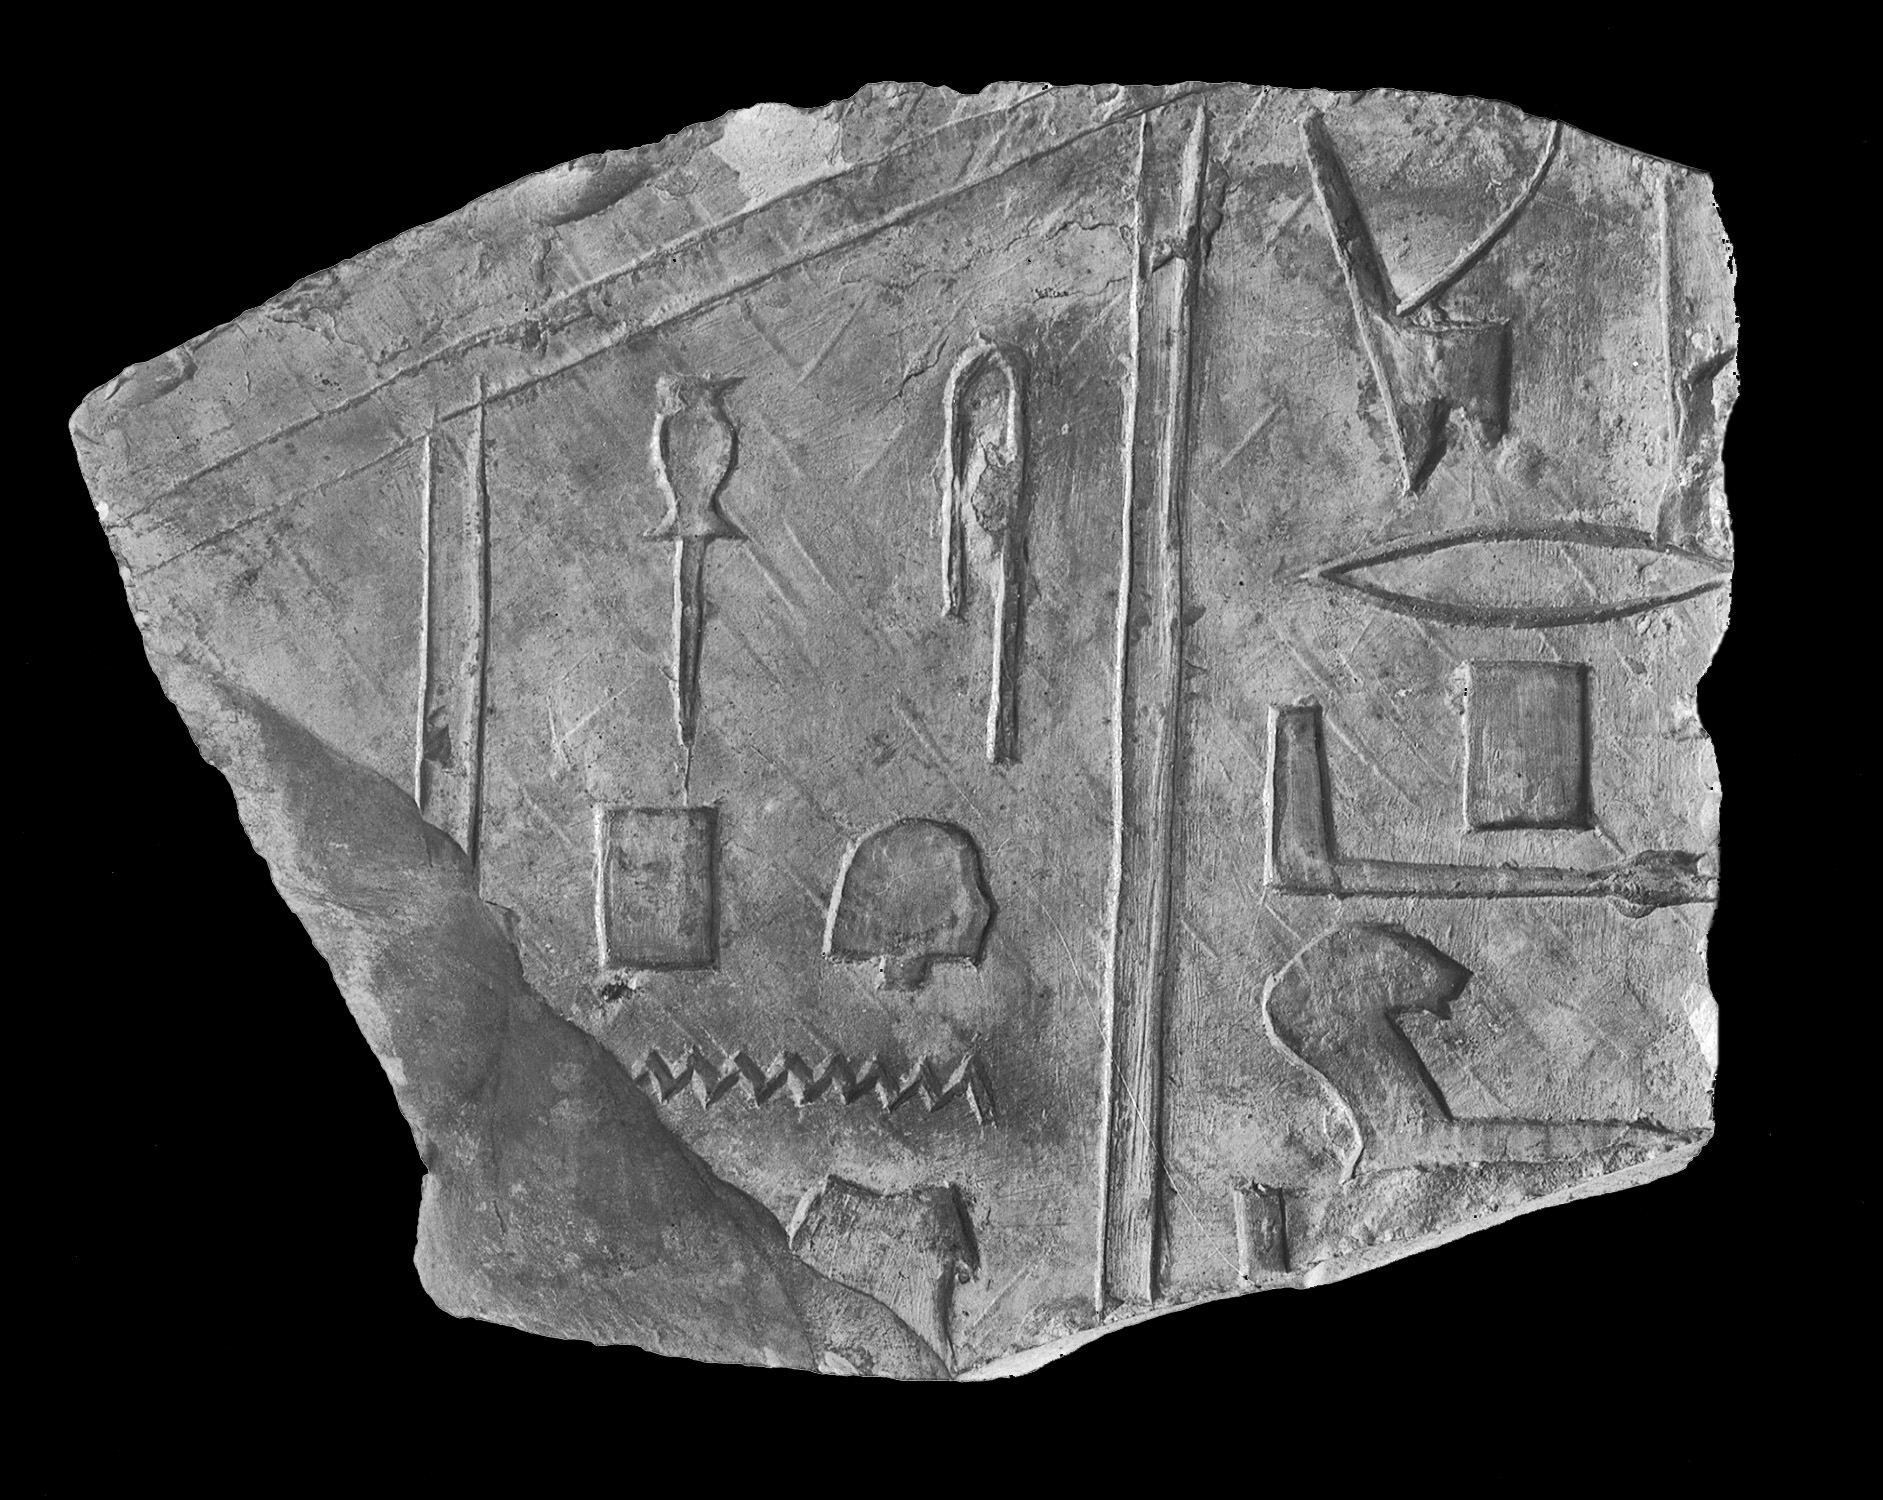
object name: relief, tomb of nespekashuty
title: Sunk relief fragment with titles of Nespakashuty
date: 664-610 BCE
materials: limestone, varnish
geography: egypt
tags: hieroglyphs